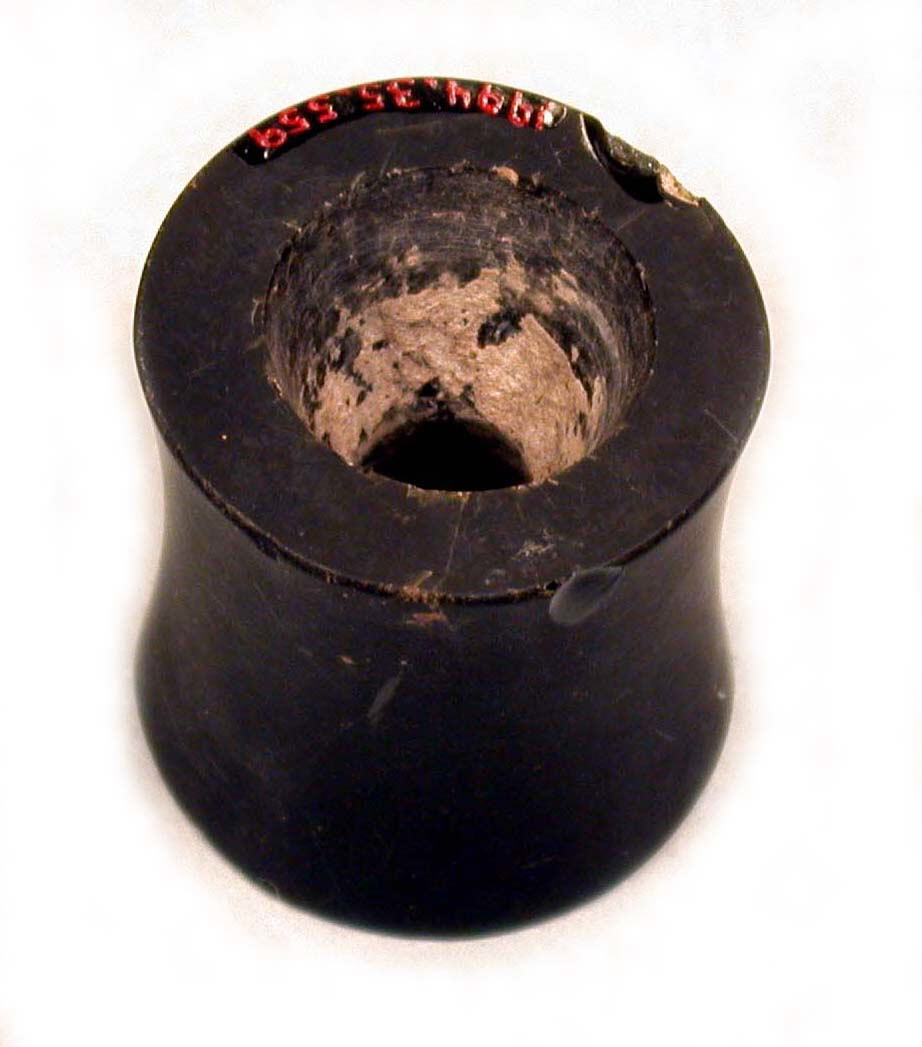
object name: ear spool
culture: mexican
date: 1501-1600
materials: obsidian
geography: mexico